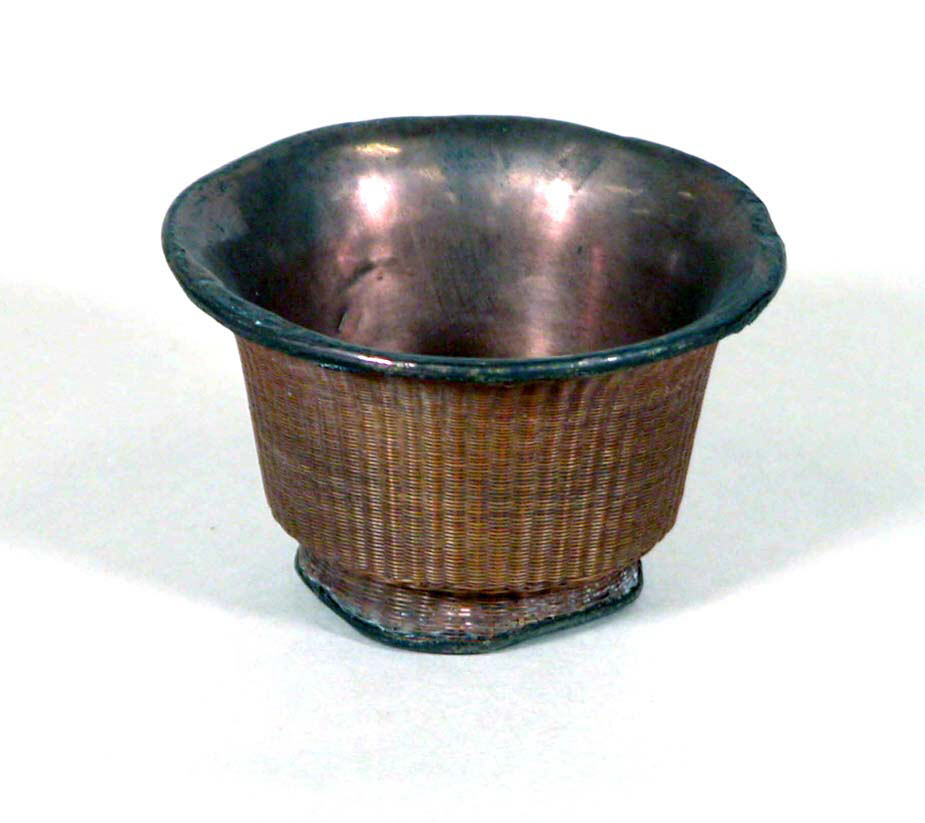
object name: cup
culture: chinese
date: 1701-1800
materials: bamboo, lacquer